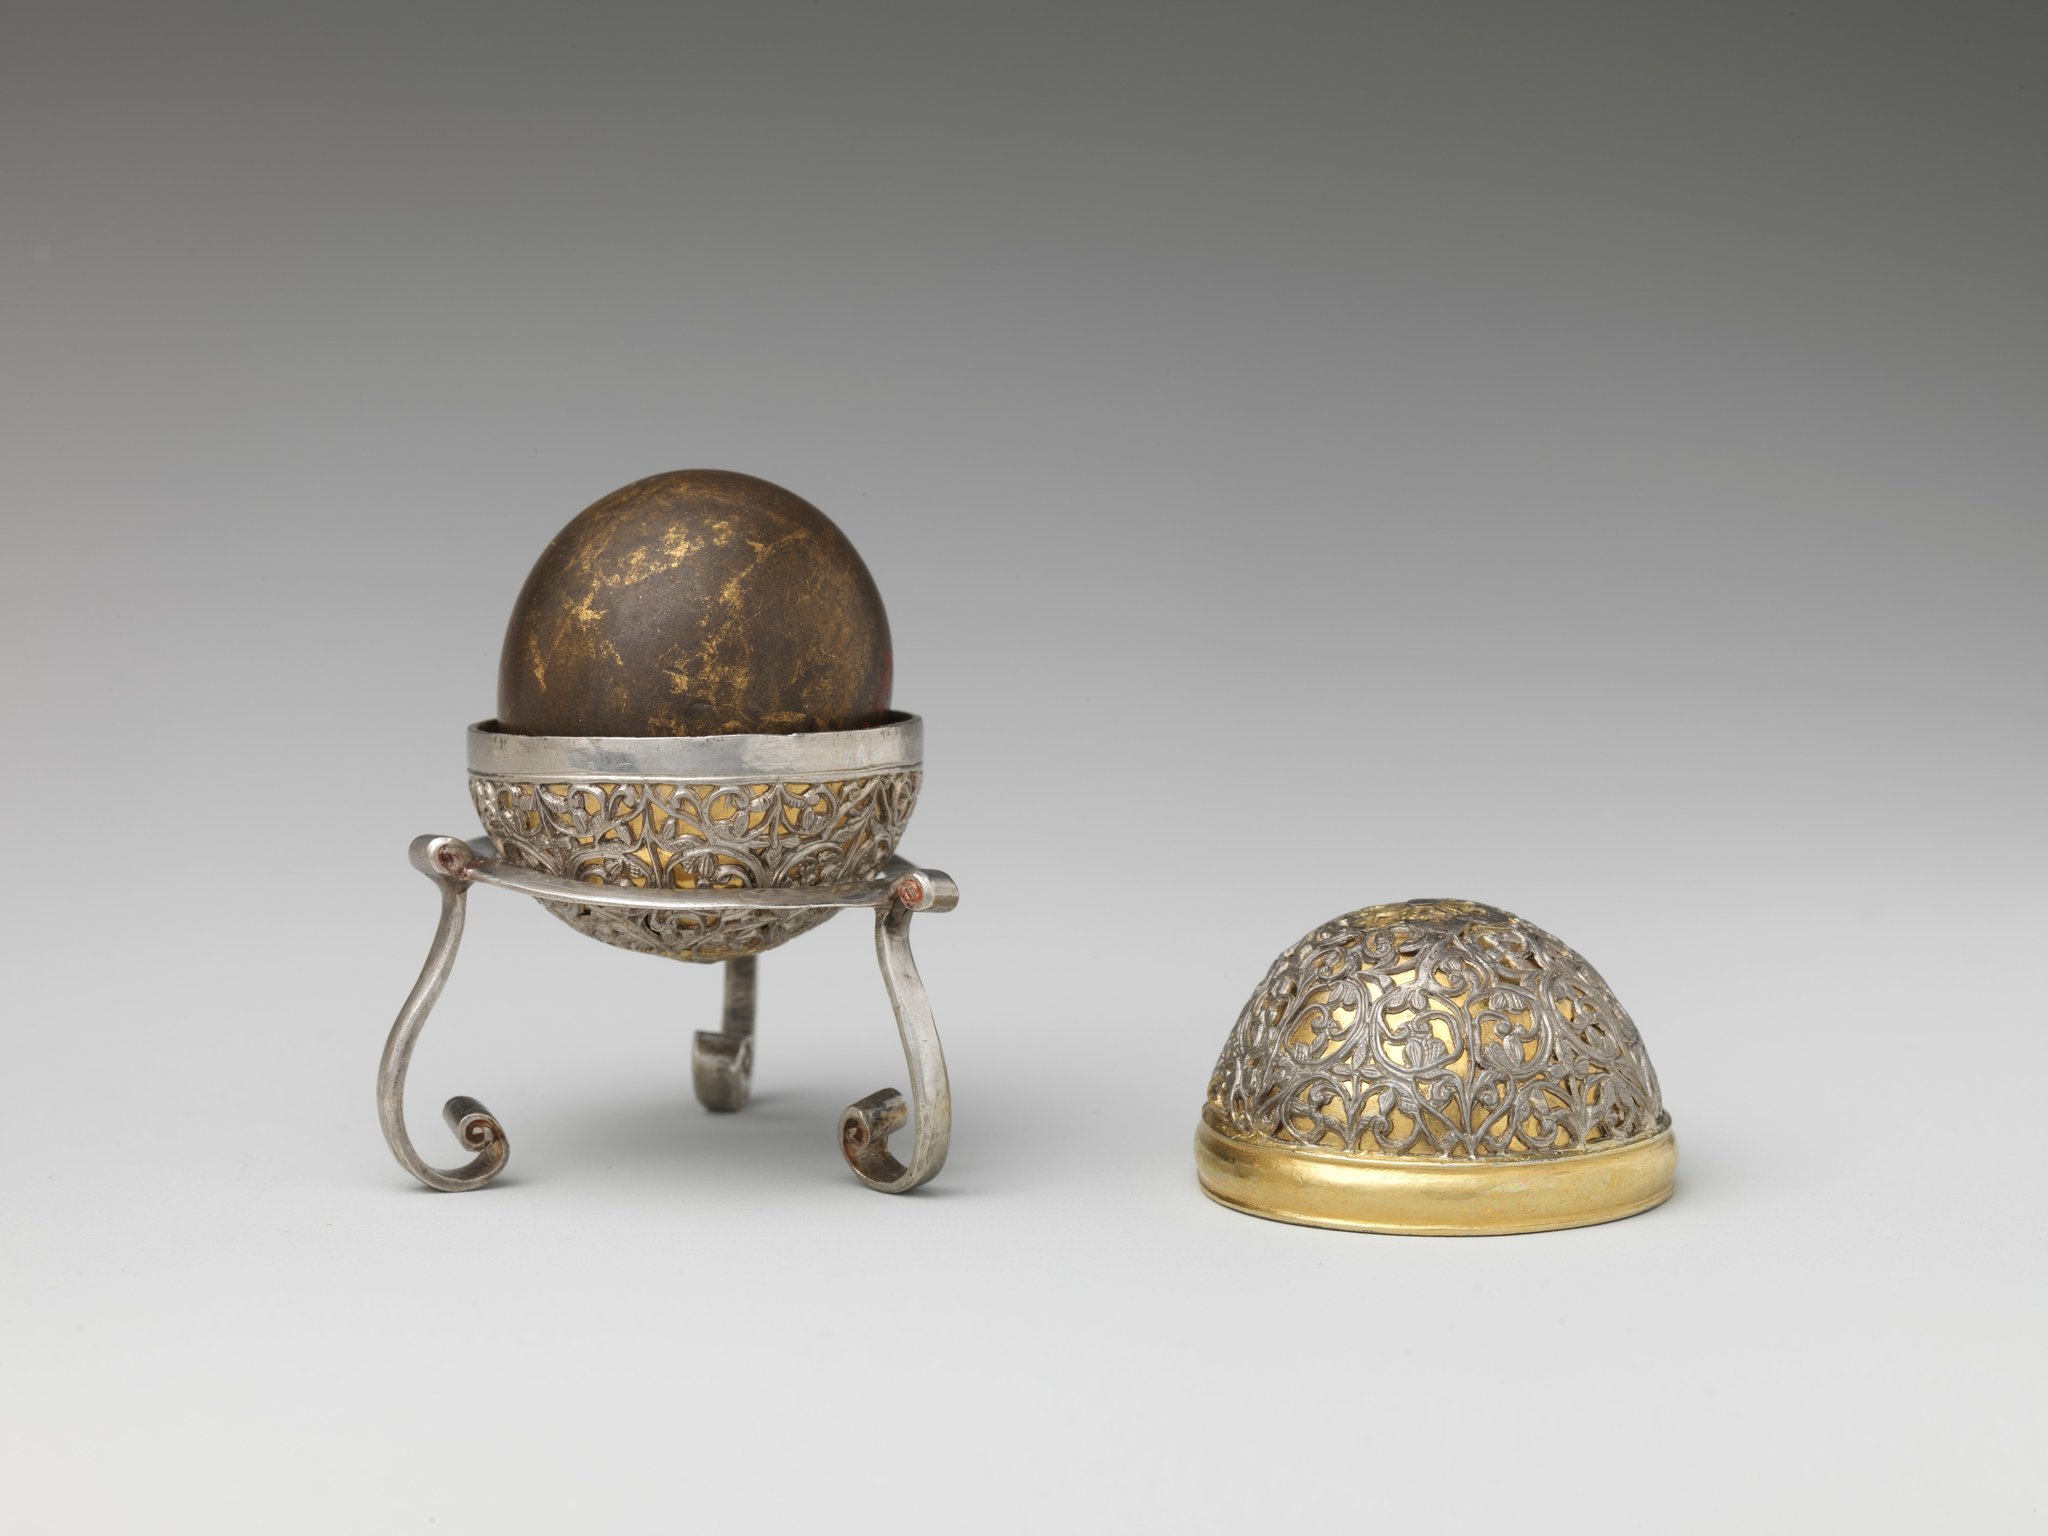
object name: bezoar stone with case and stand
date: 1601-1700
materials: mercury, silver, stone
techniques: chasing, gilding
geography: india